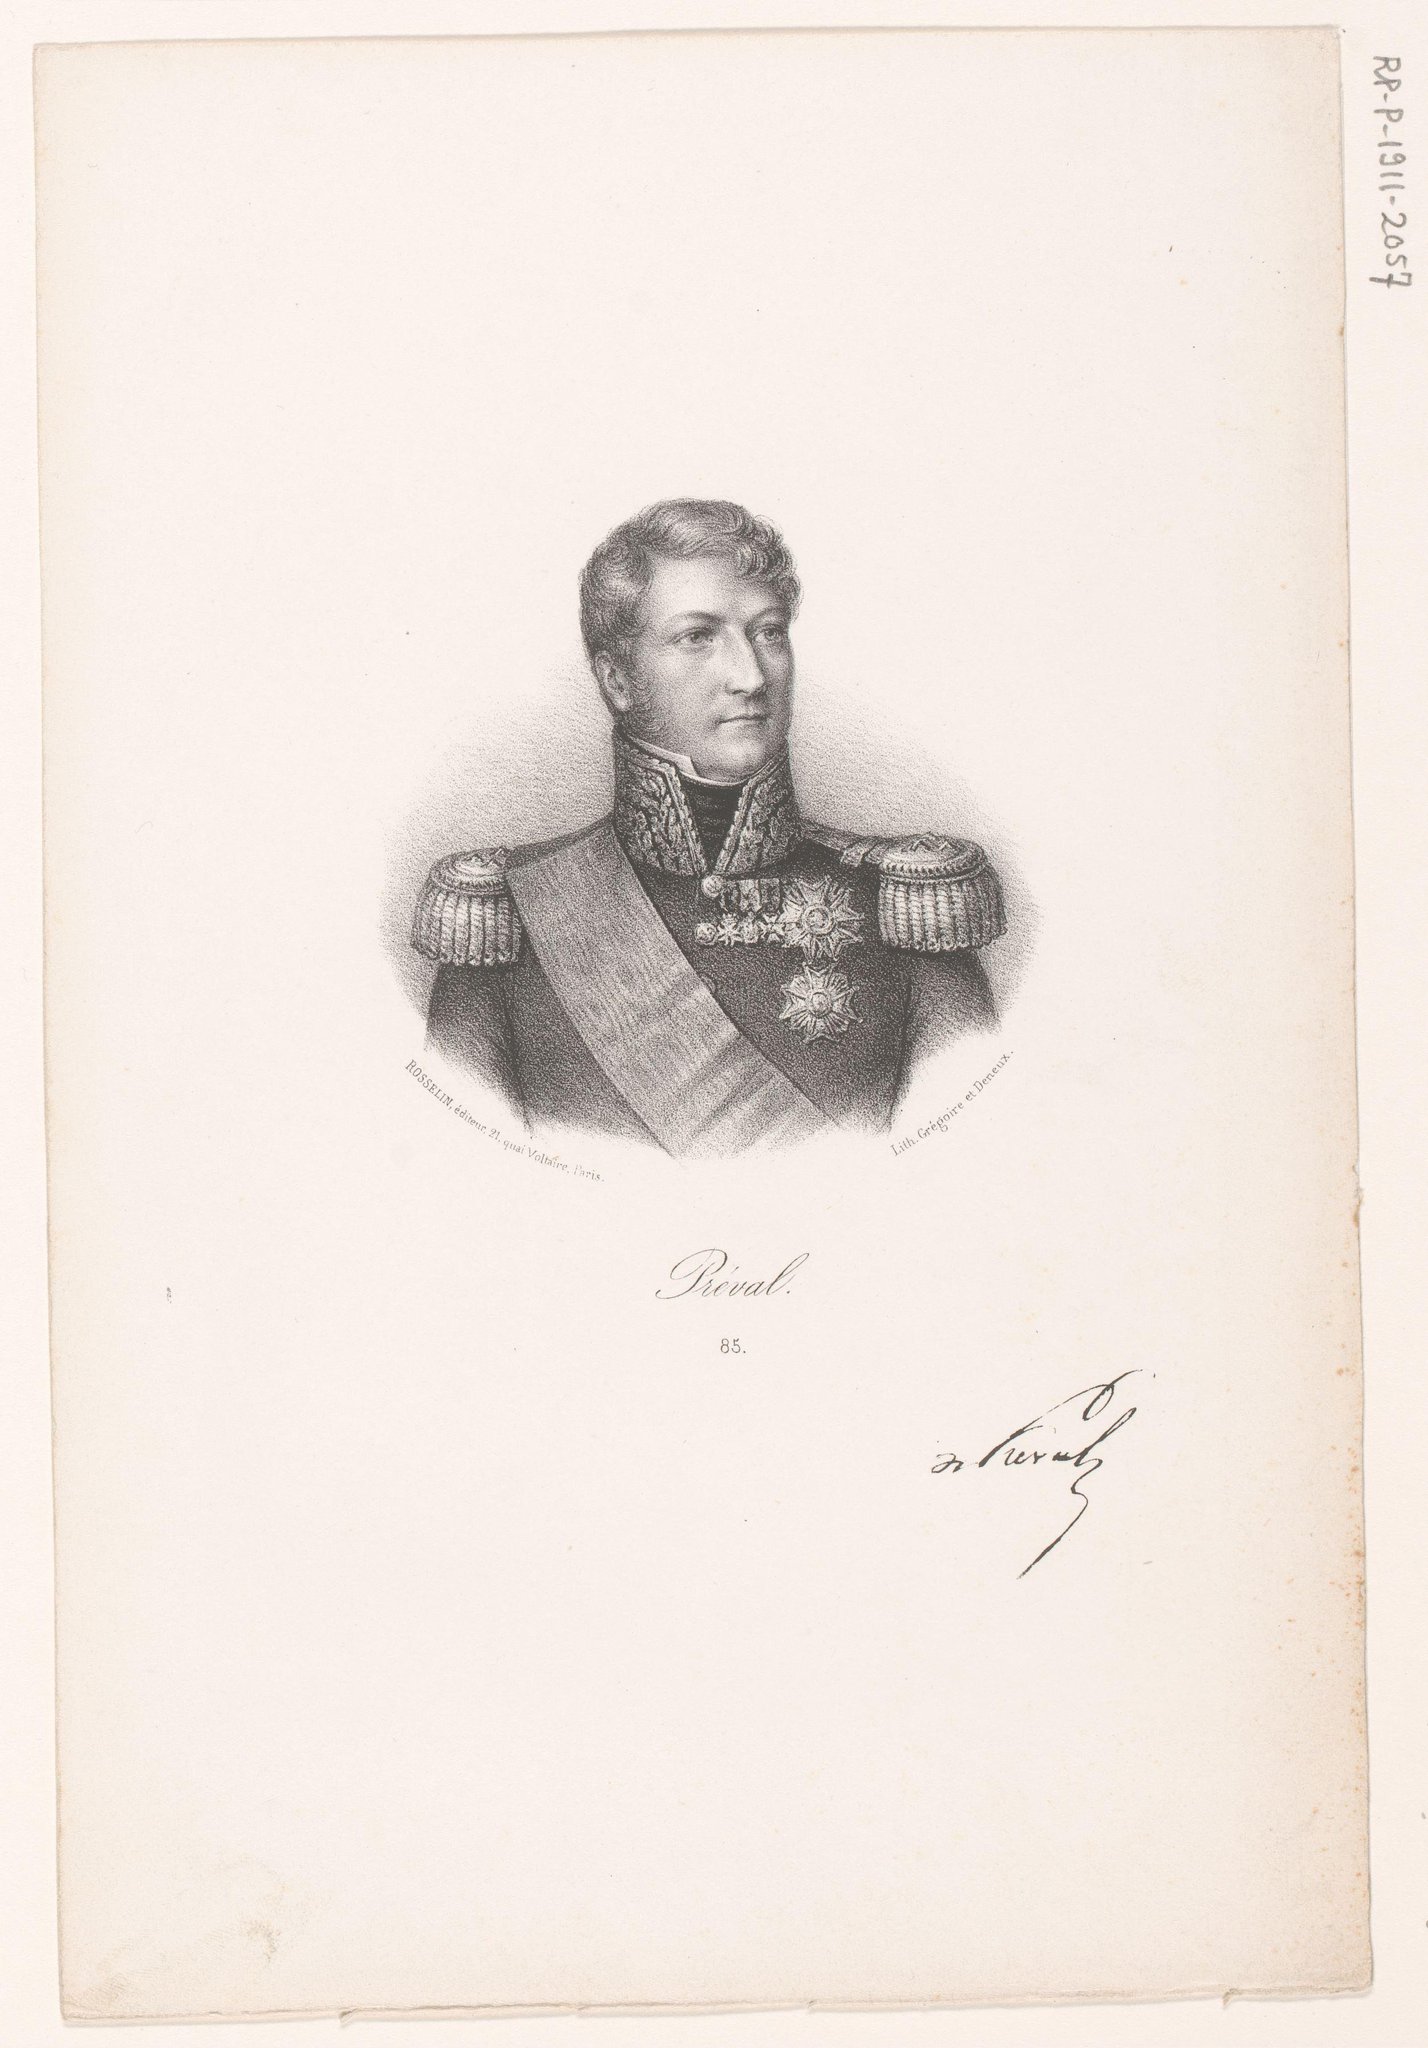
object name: print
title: Beroemde personen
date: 1844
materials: paper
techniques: lithograph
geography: paris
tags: paris, politician, historical persons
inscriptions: collector's mark: Lugt 2228a